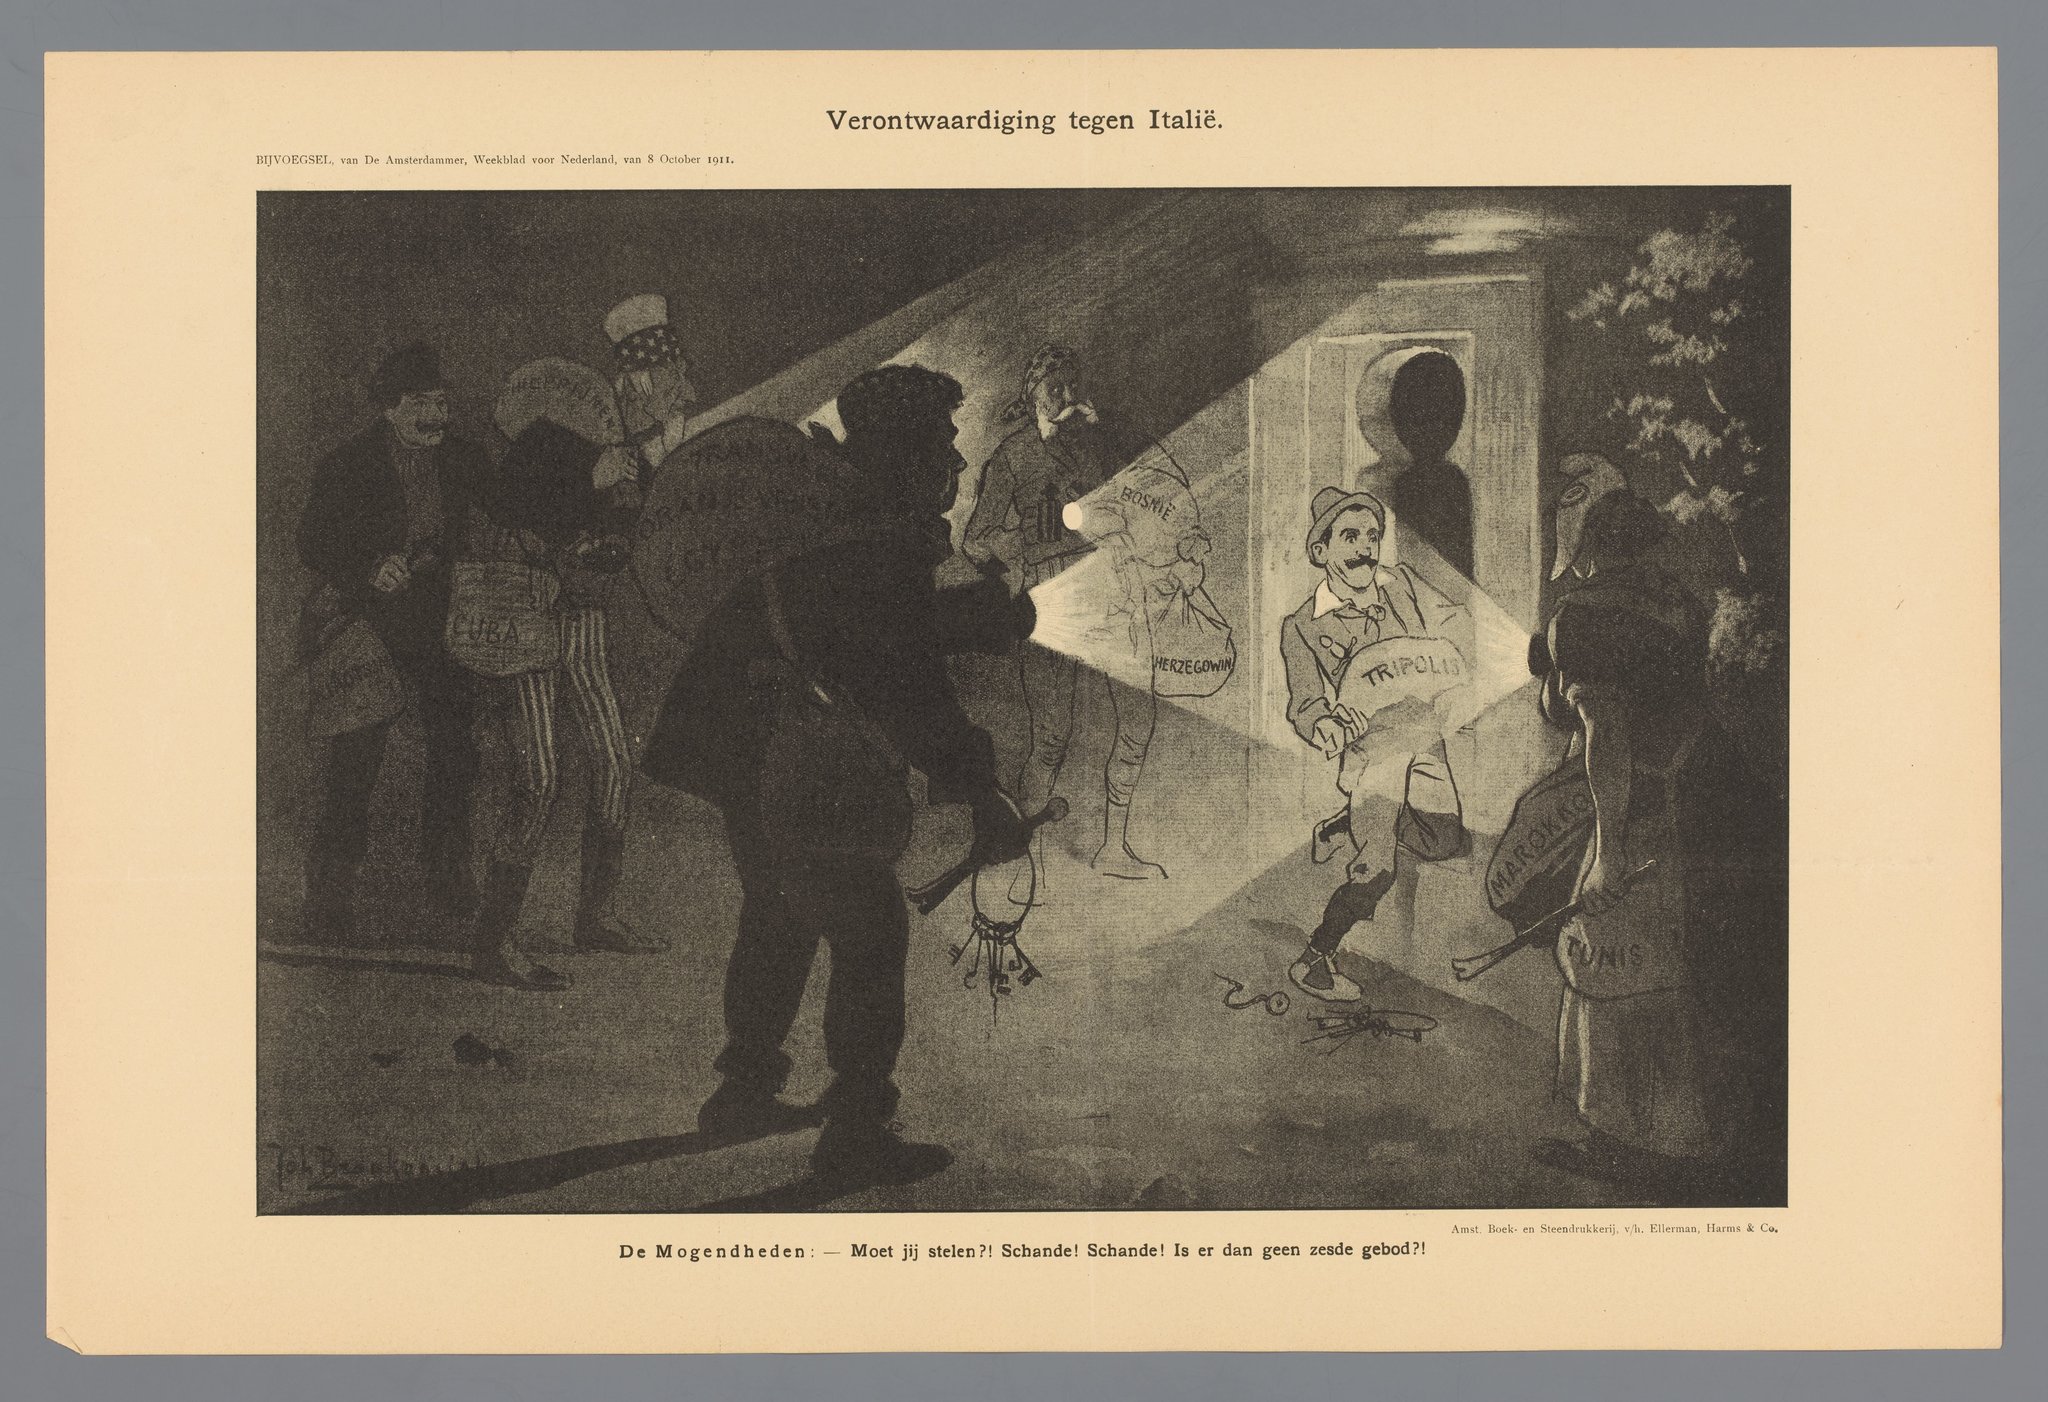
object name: cartoon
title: Verontwaardiging tegen Italië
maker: johan braakensiek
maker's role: draughtsman, print maker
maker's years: 1858-1940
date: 1911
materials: paper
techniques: lithograph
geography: amsterdam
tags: thief, personifications of countries, nations, states, districts, etc. (+ nation; national), 'you shall not steal' ~ separate representation of the eigth of the ten commandments, political caricatures and satires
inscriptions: date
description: Prent uit het bijvoegsel van: De Amsterdammer. Weekblad voor Nederland, 8 oktober 1911.